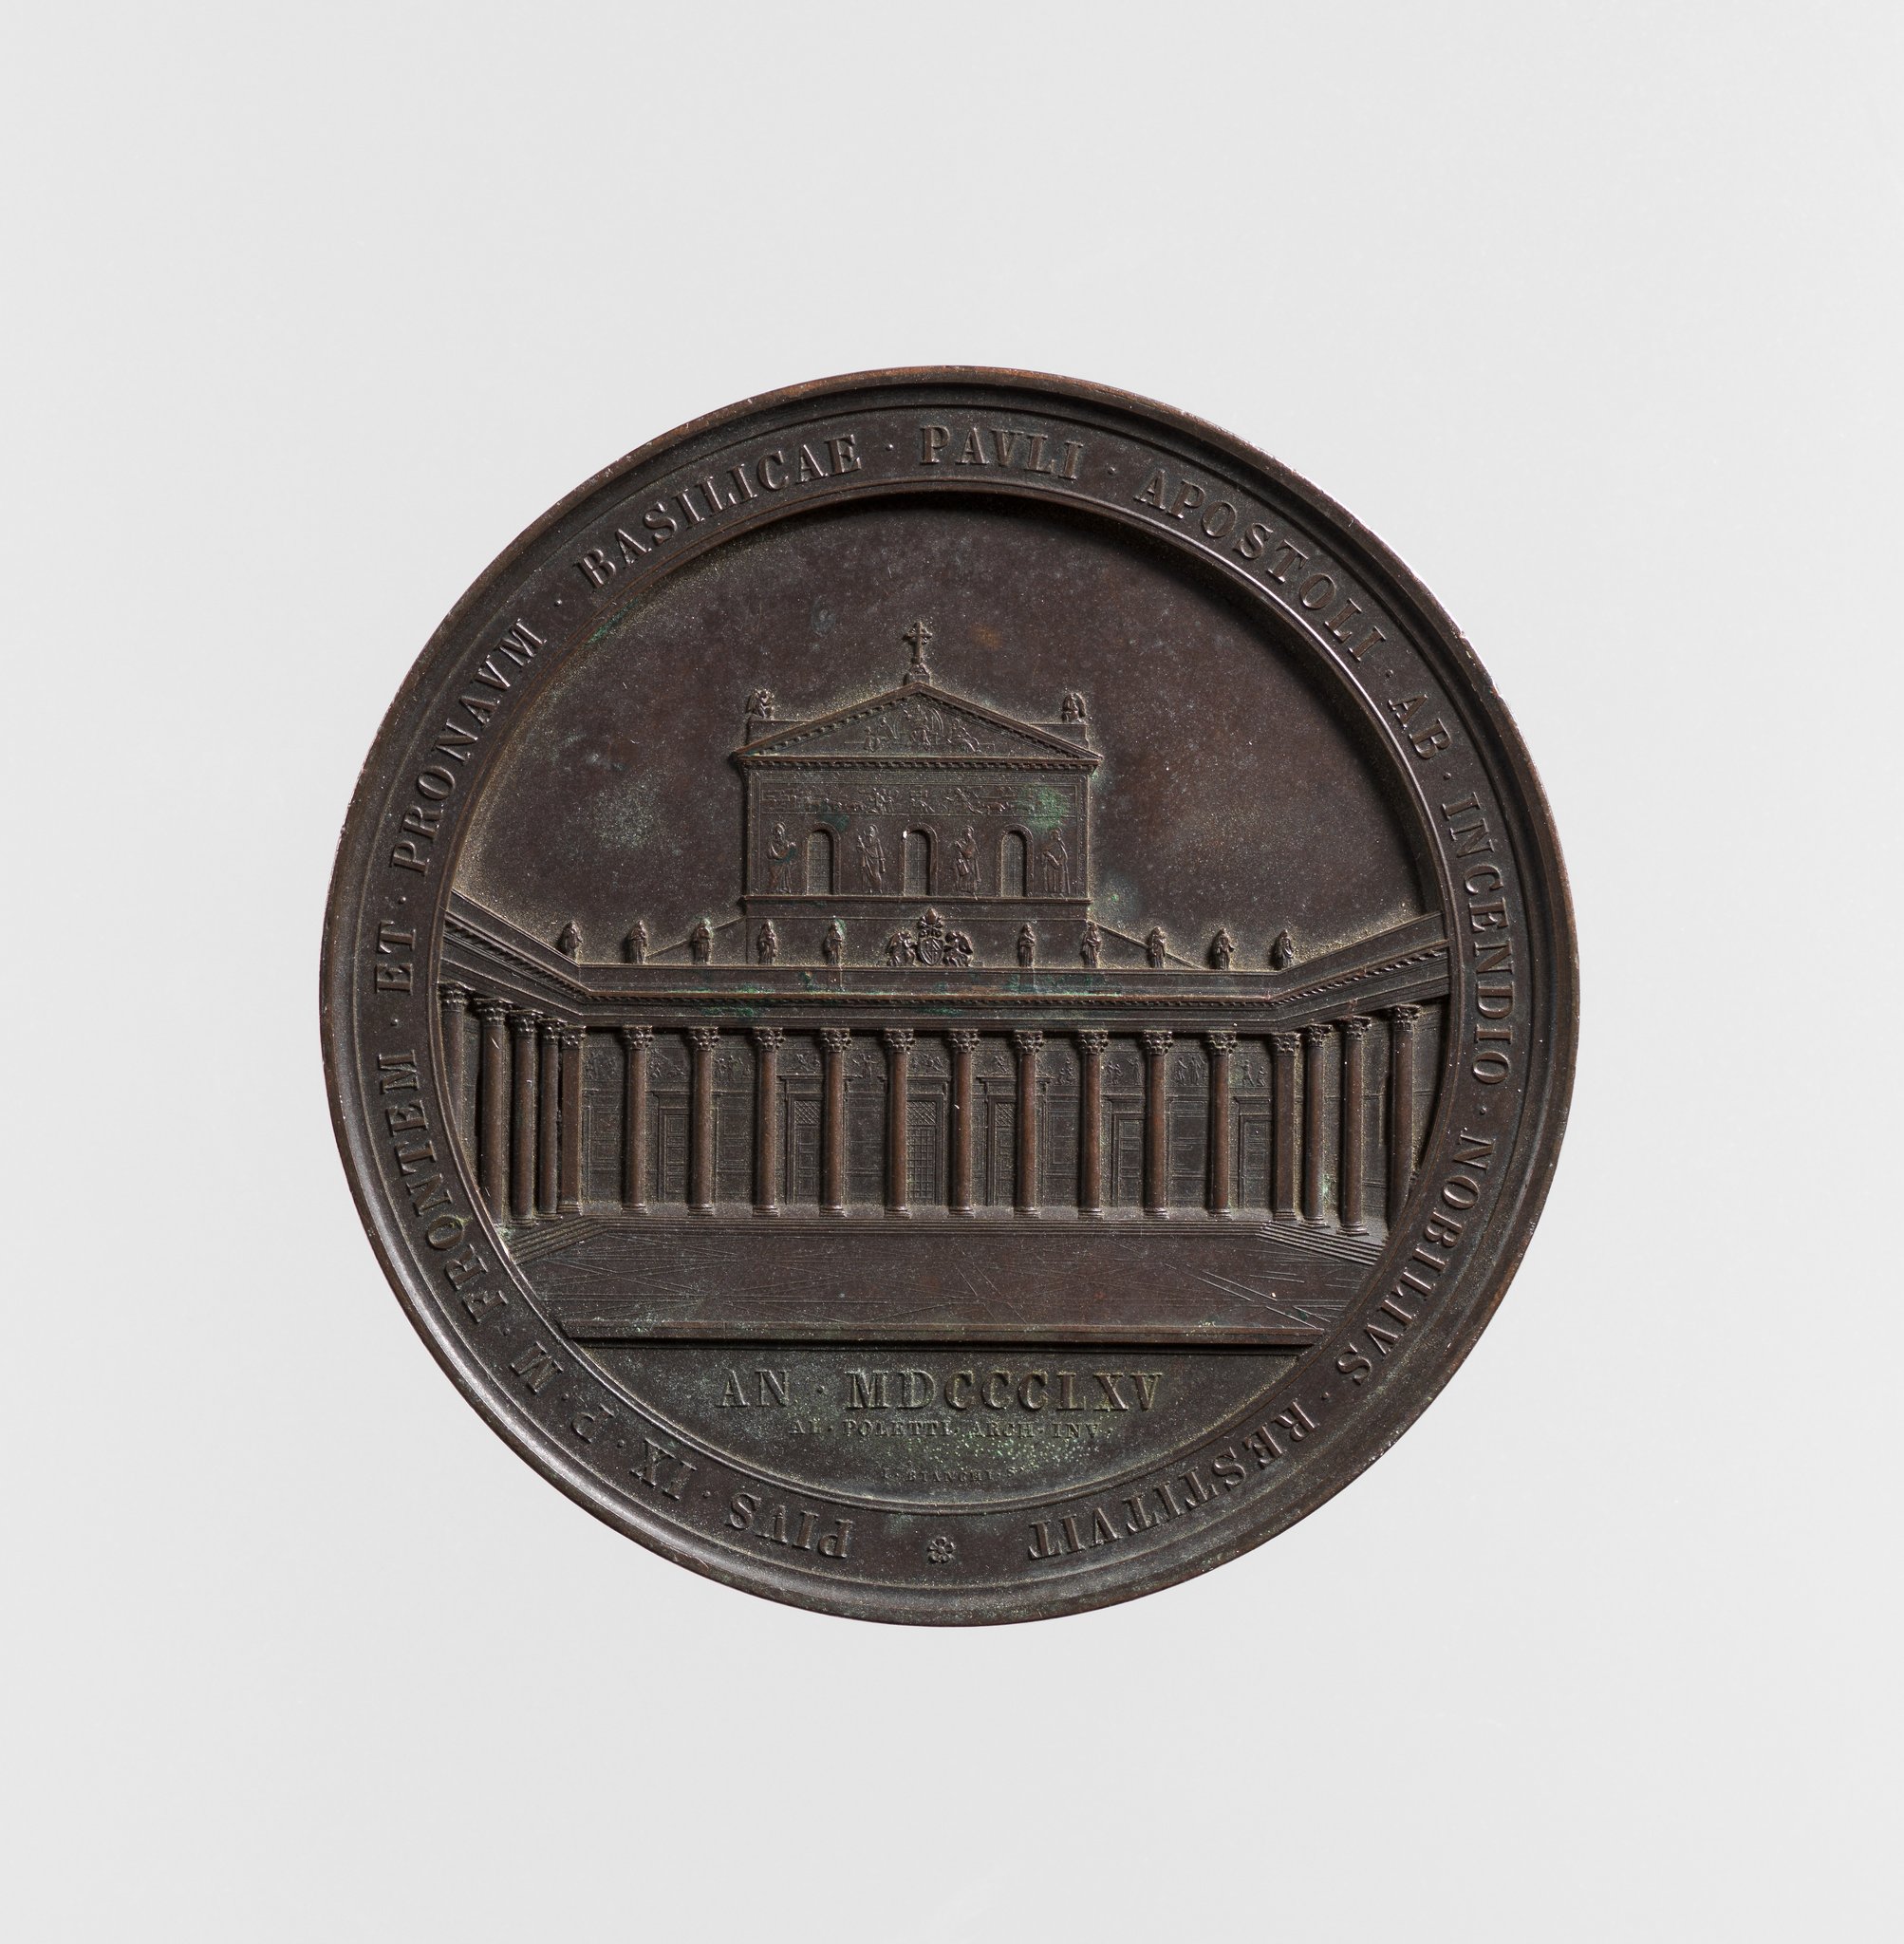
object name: pontifical medal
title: Reconstruction and Re-consecration of the Basilica of Saint Paul Outside the Walls under Pope Pius IX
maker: giuseppe bianchi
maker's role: maker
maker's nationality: italian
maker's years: 1808-1877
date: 1865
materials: bronze